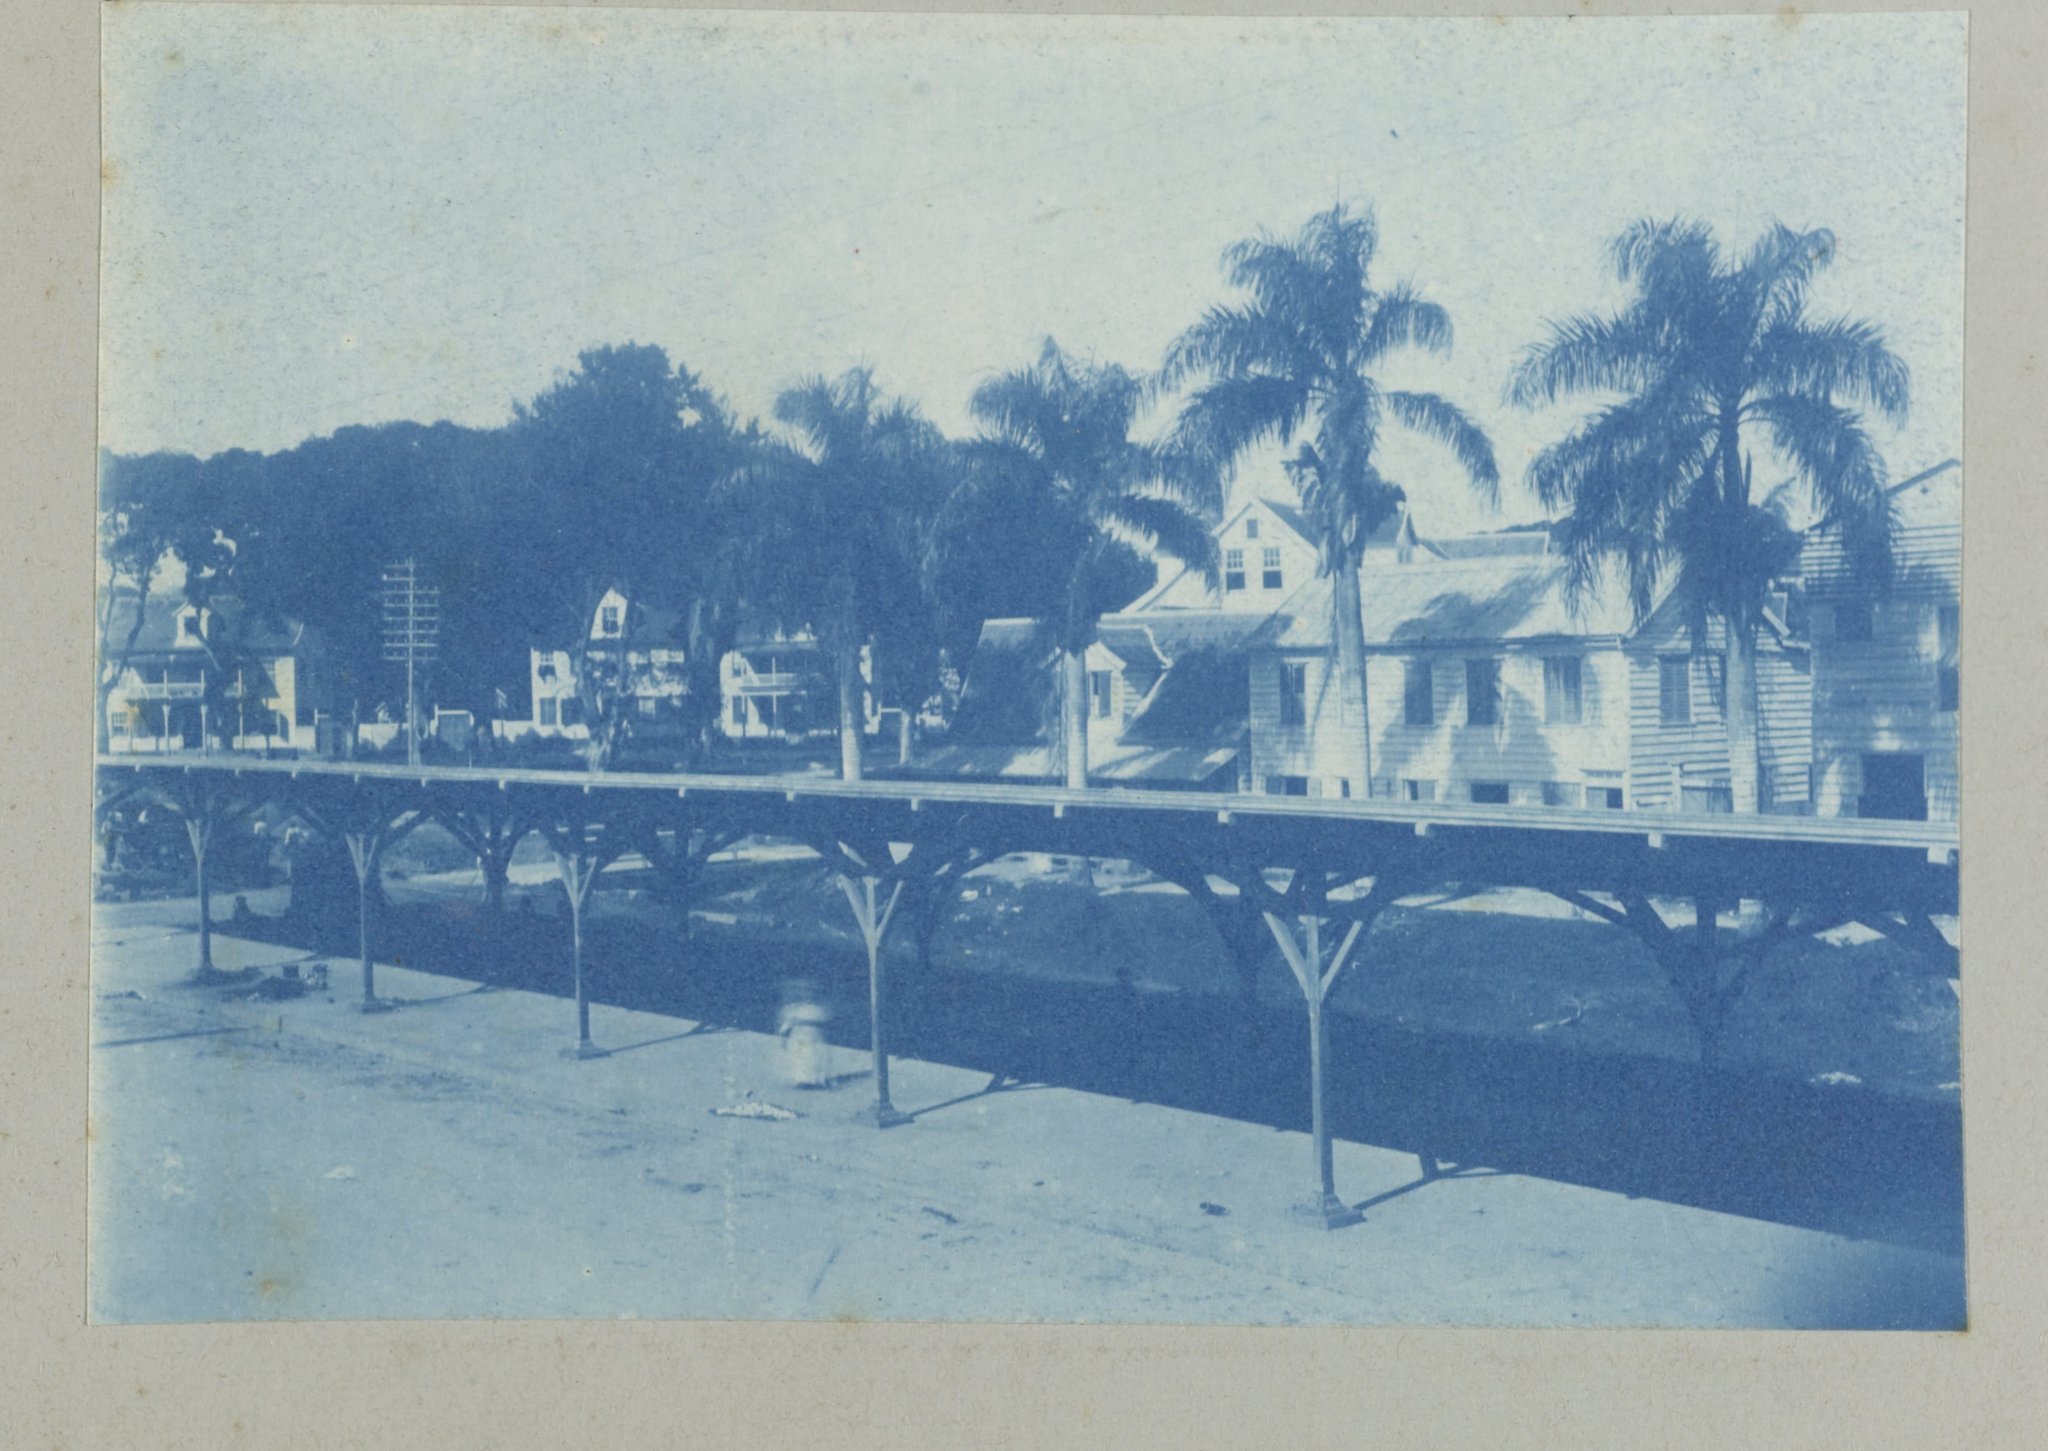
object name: photograph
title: Heiligenweg te Paramaribo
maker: hendrik doijer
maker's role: engineer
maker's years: 1863-1925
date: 1903-1910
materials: photographic support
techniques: cyanotype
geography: suriname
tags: suriname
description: Gezicht op de Heiligenweg met een overdekte passage, te Paramaribo. Onderdeel van het fotoalbum Souvenir de Voyage (deel 1), over het leven van de familie Doijer in en rond de plantage Ma Retraite in Suriname in de jaren 1903-1910.